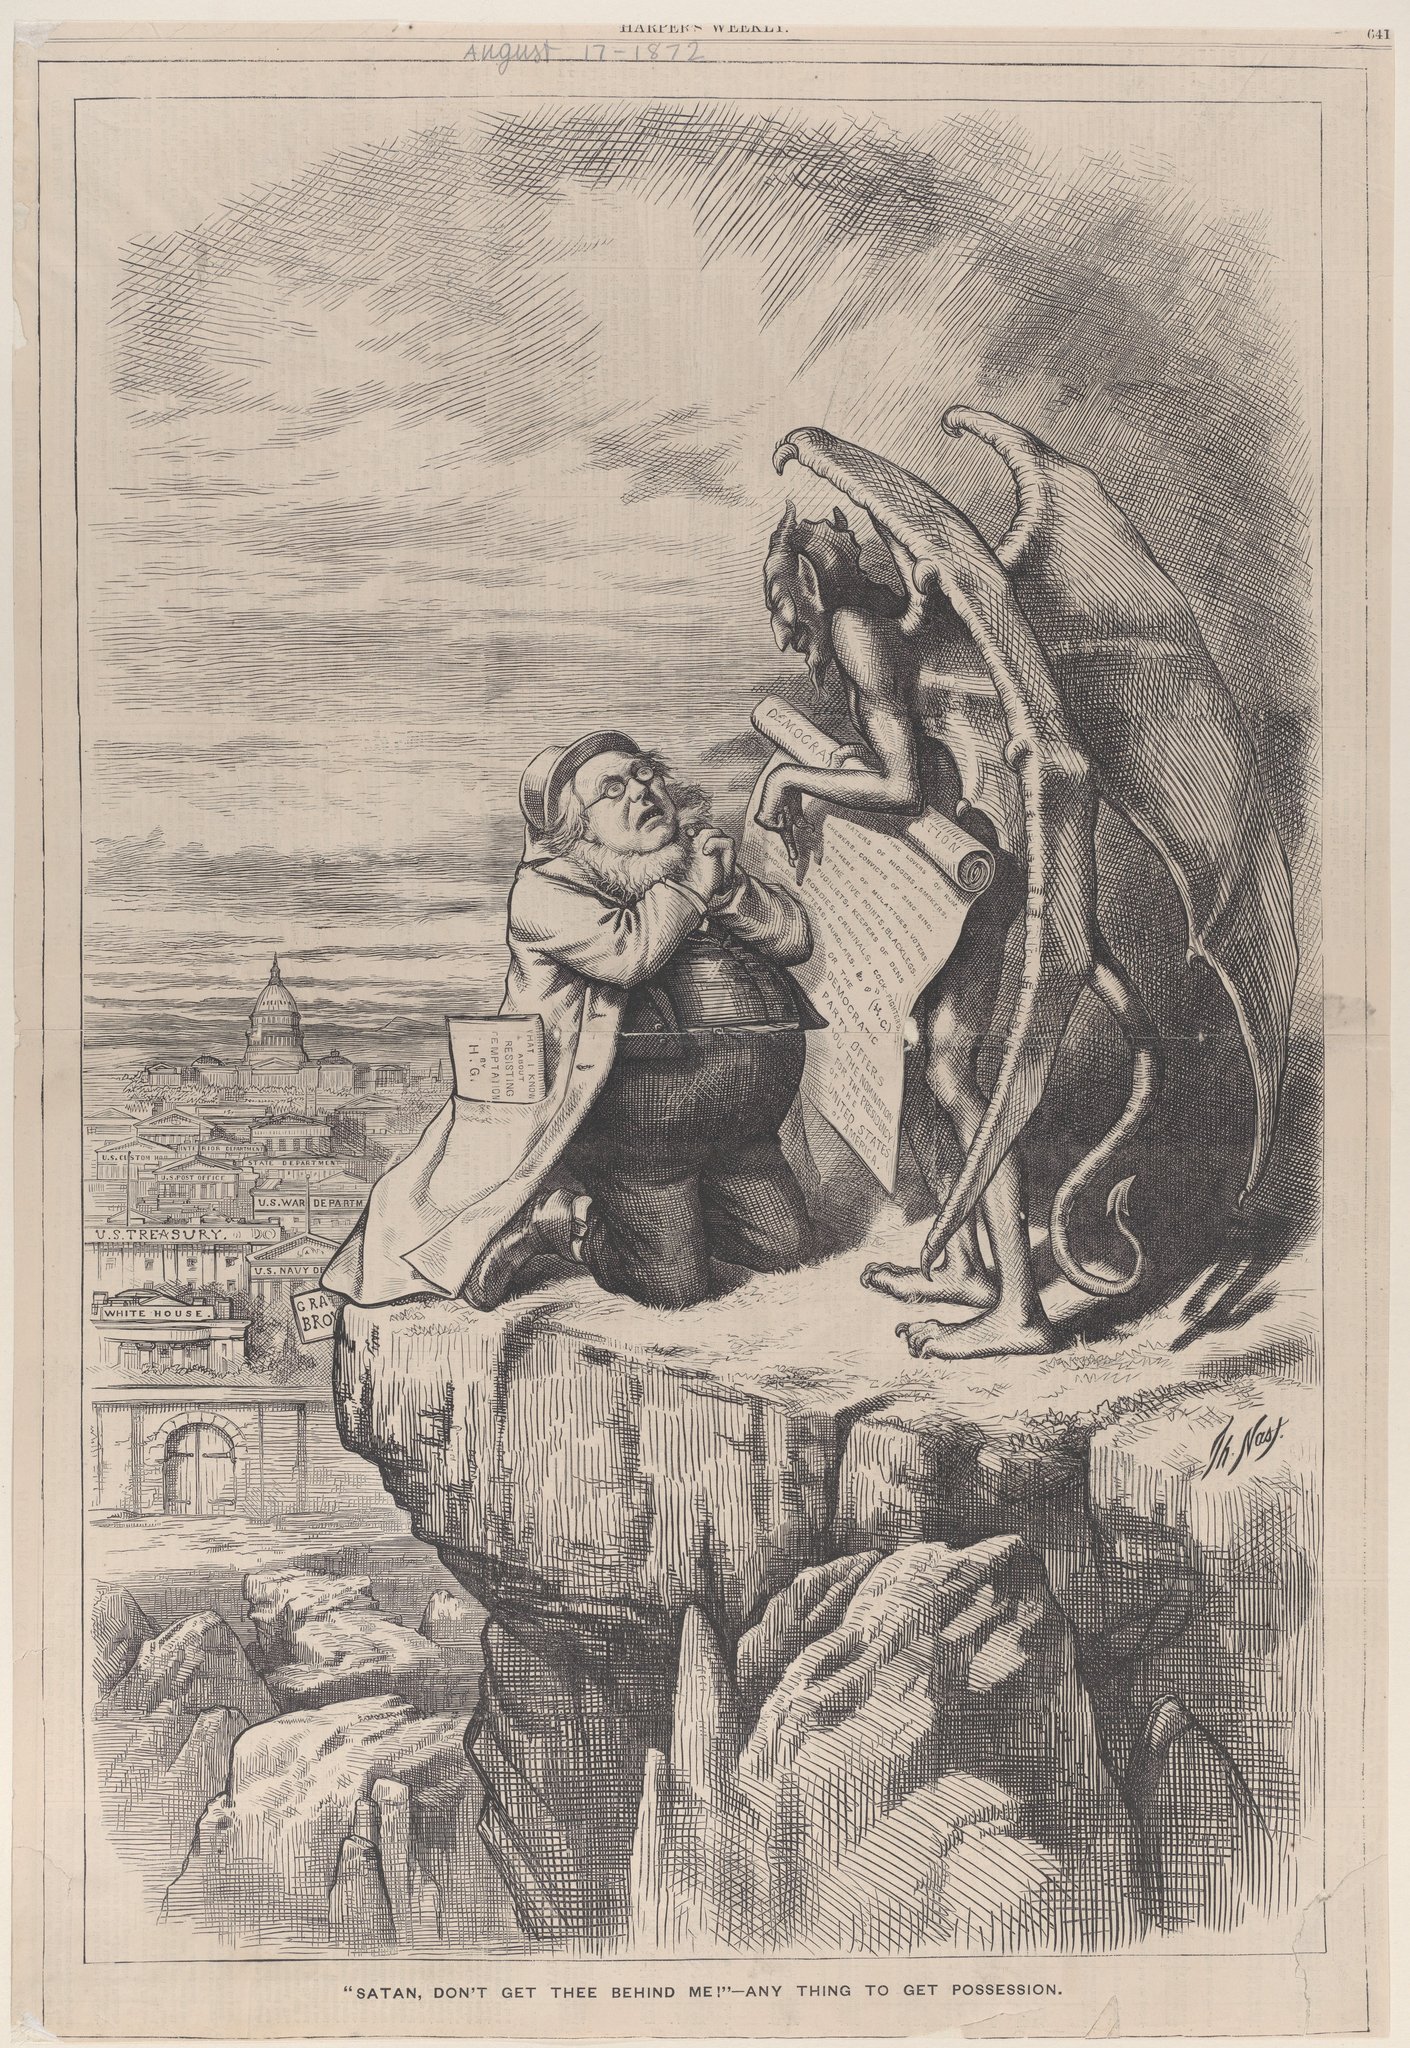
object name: print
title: "Satan, Don't Get Thee Behind Me!"–Anything to Get Possession, from "Harper's Weekly," vol. 16, p. 641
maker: thomas nast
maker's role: artist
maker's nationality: american, born germany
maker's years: 1840-1902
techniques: engraving